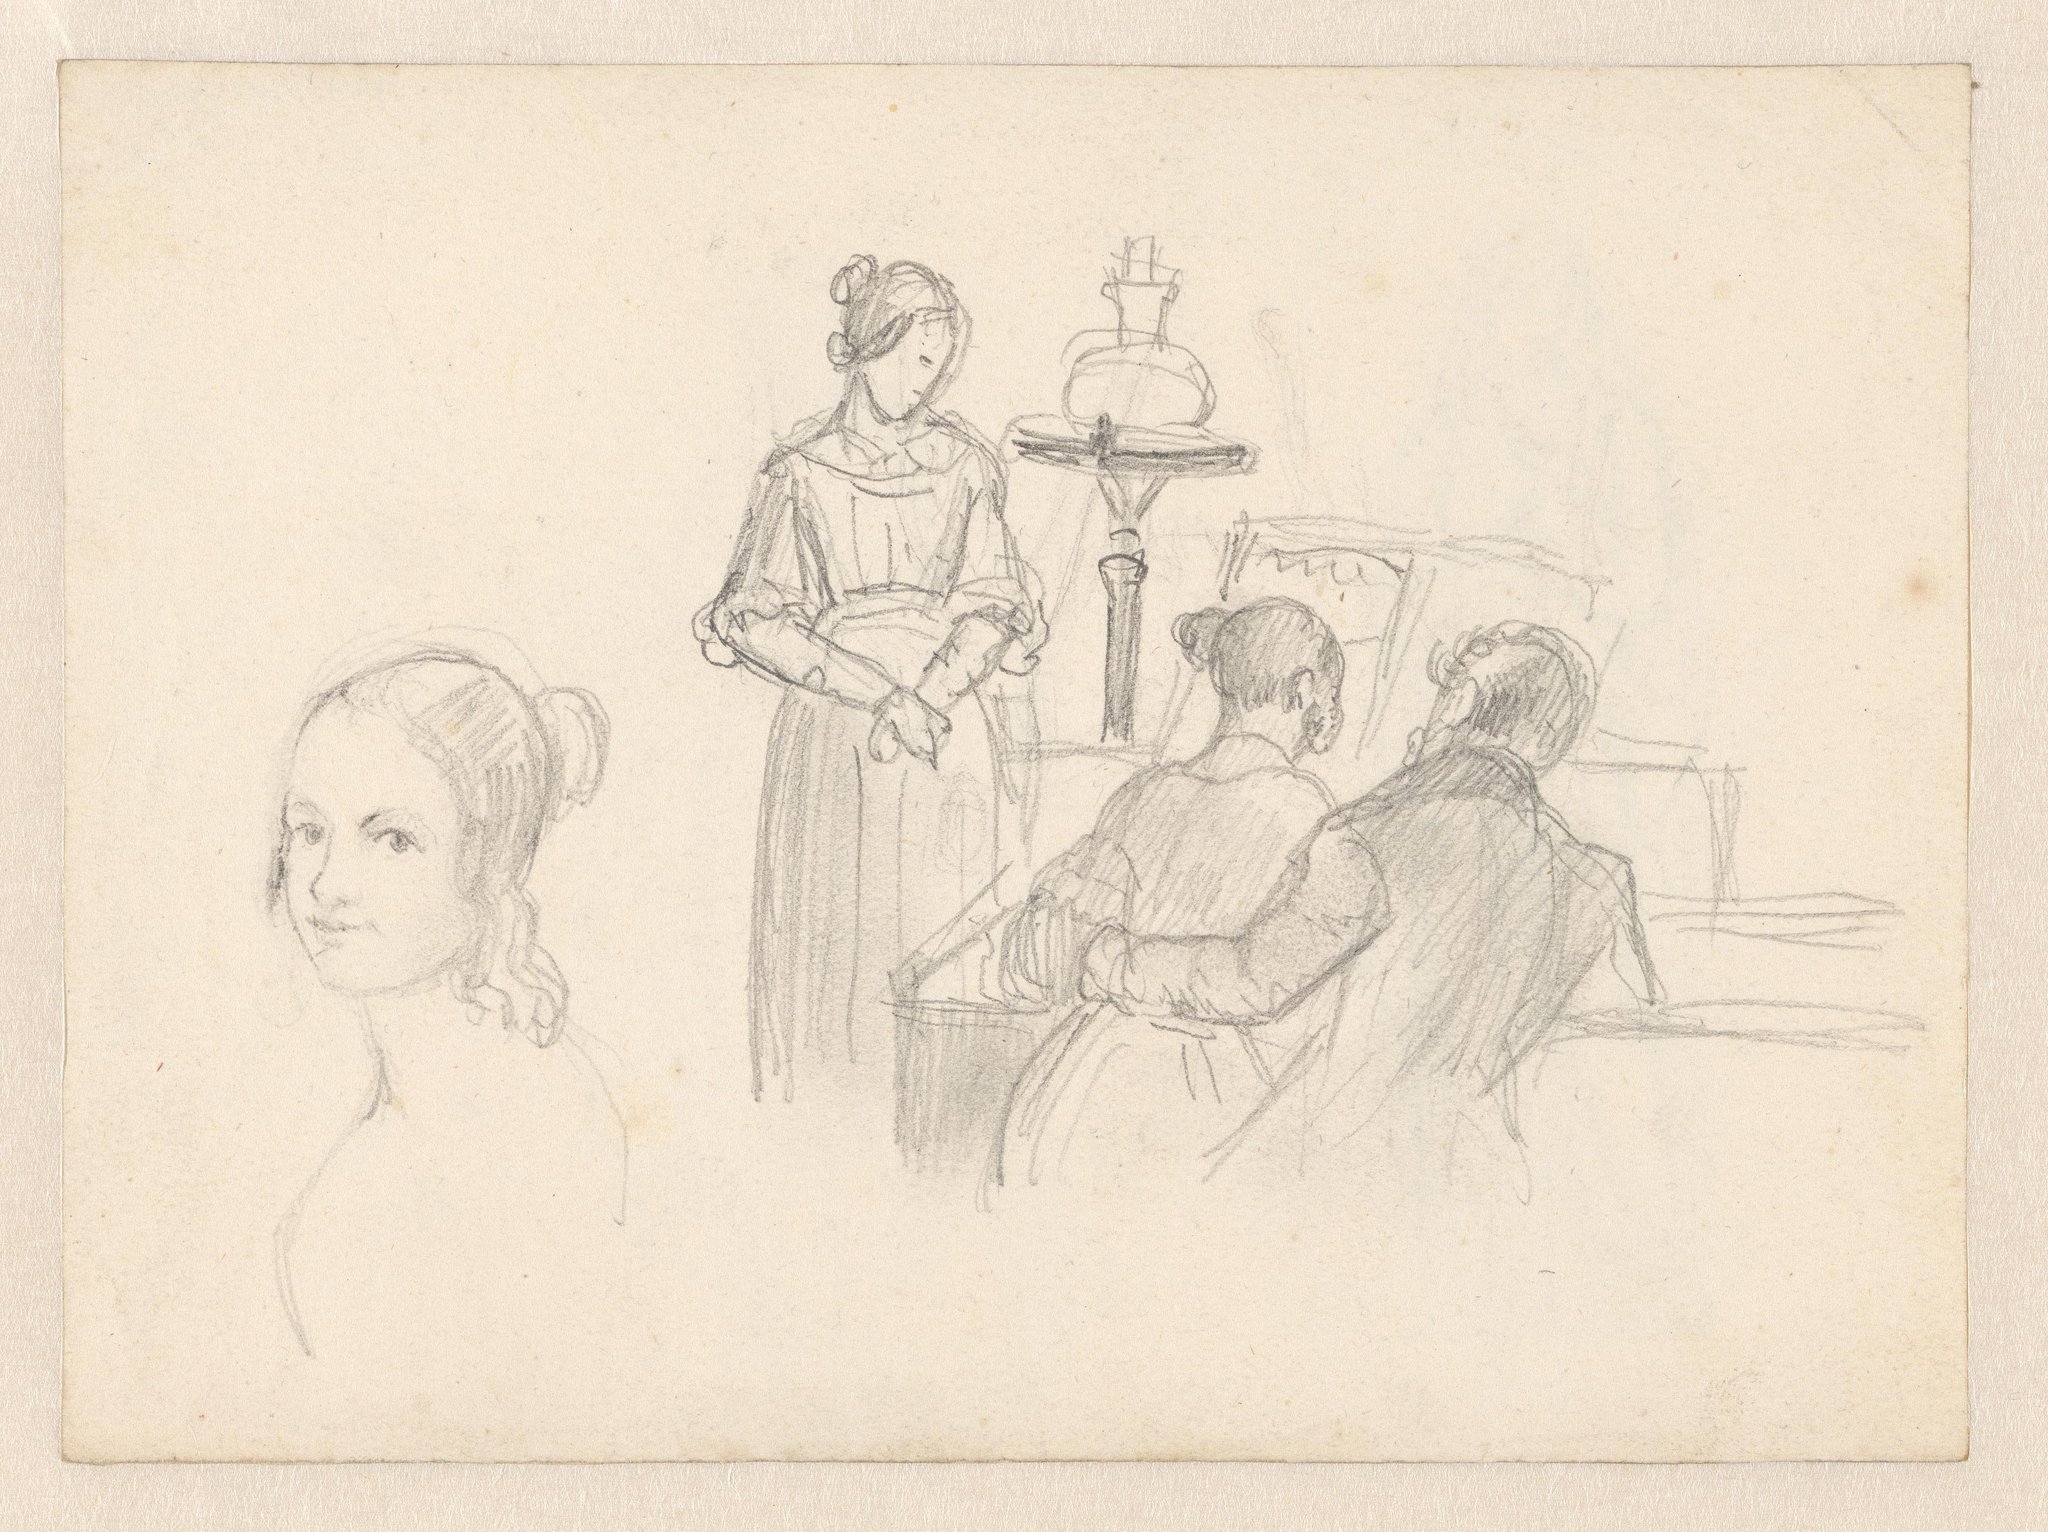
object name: drawing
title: Schetsblad met musicerend paar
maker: louis royer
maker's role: draughtsman, sculptor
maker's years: 1793-1868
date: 1808-1868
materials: paper, pencil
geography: netherlands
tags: adolescent, young woman, maiden, making music; musician with instrument